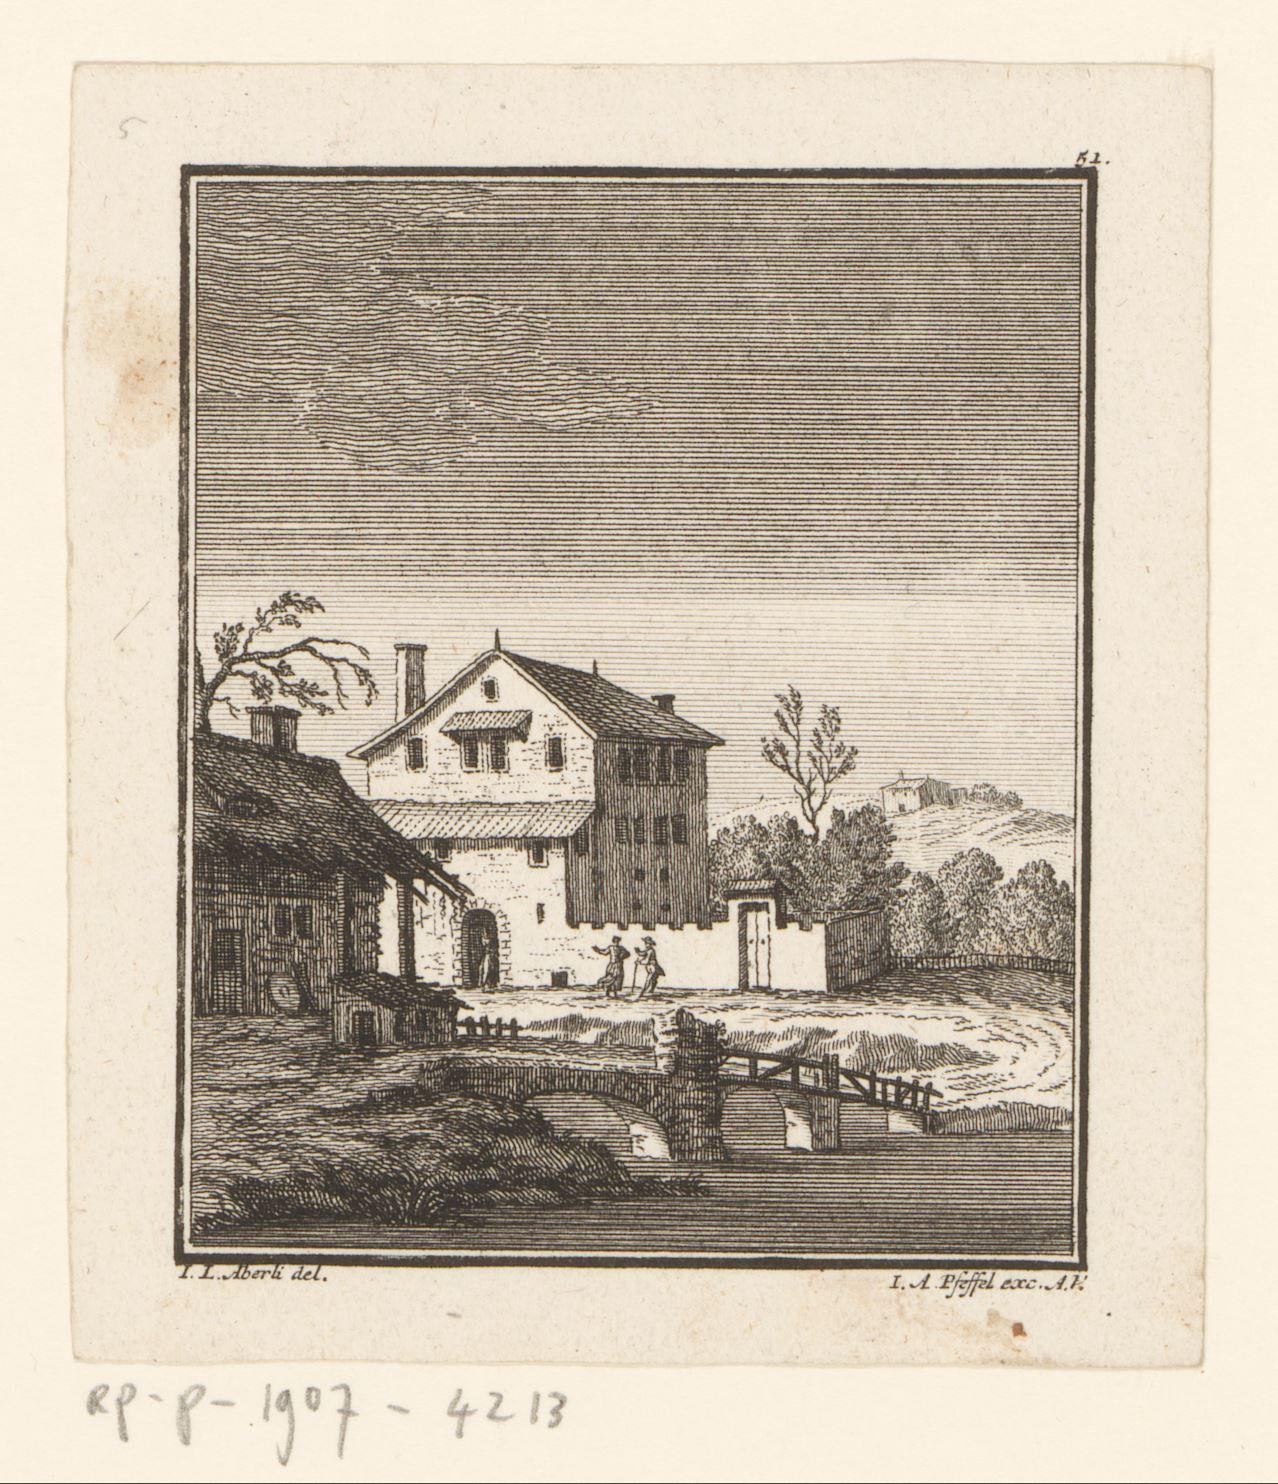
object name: print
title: Gezicht op een landhuis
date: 1733-1786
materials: paper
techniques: etching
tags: city-view, and landscape with man-made constructions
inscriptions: collector's mark: Lugt 2228